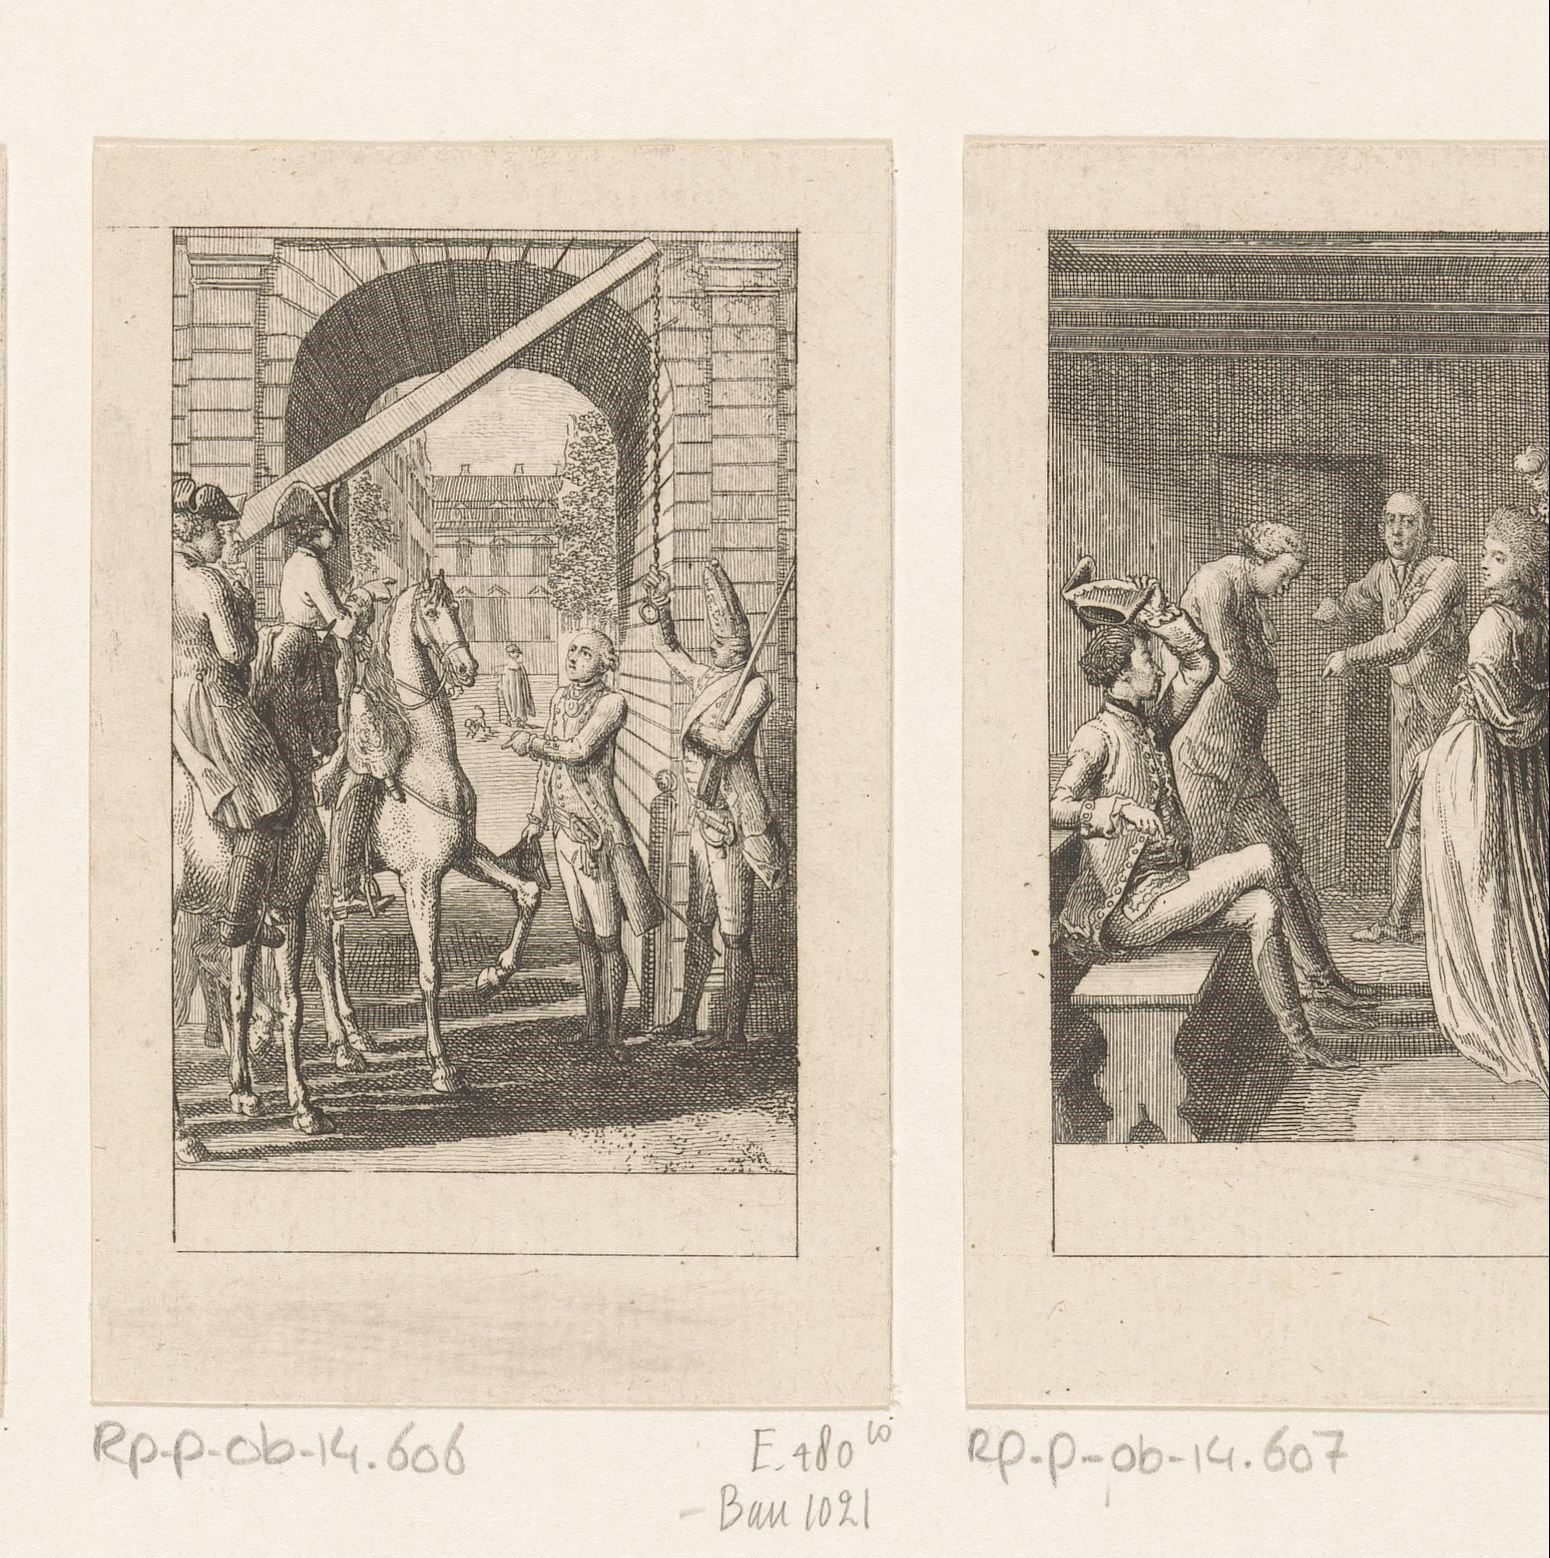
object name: print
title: Jonkheer Siegfried weigert aan de poort zijn ware identiteit te onthullen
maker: daniel nikolaus chodowiecki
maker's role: draughtsman, print maker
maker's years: 1726-1801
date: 1783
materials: paper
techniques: etching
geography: berlin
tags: city-view, and landscape with man-made constructions, gate ~ fortified city, literature, disguise, horse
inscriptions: collector's mark: Lugt 2228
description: Vervaardigd voor J. G. Müller's 'Siegfried von Lindenberg'. Een latere staat gebruikt in: Goettinger Taschen Calender vom Jahr 1784. bey Joh. Chr. Dietrich. Göttingen: Georg Christoph Lichtenberg, 1784.